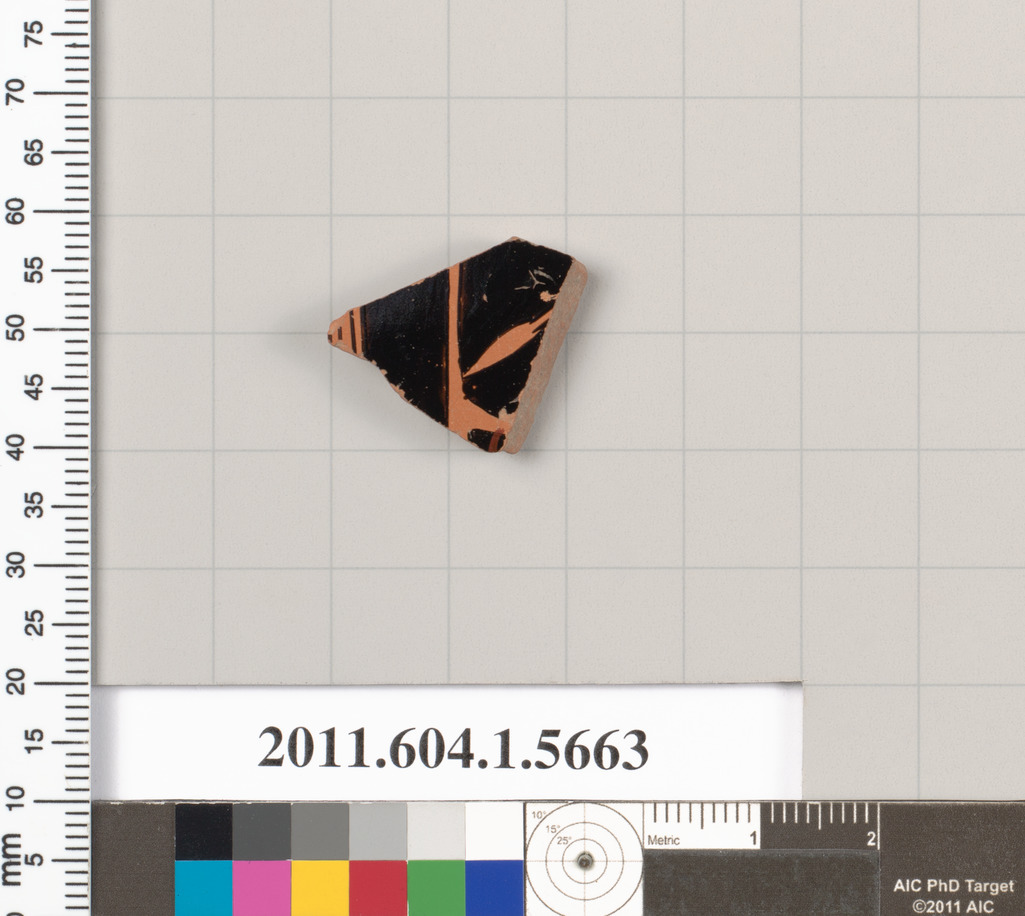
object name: kylix fragment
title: Terracotta fragment of a kylix (drinking cup)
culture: greek, attic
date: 500-480 BCE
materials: terracotta